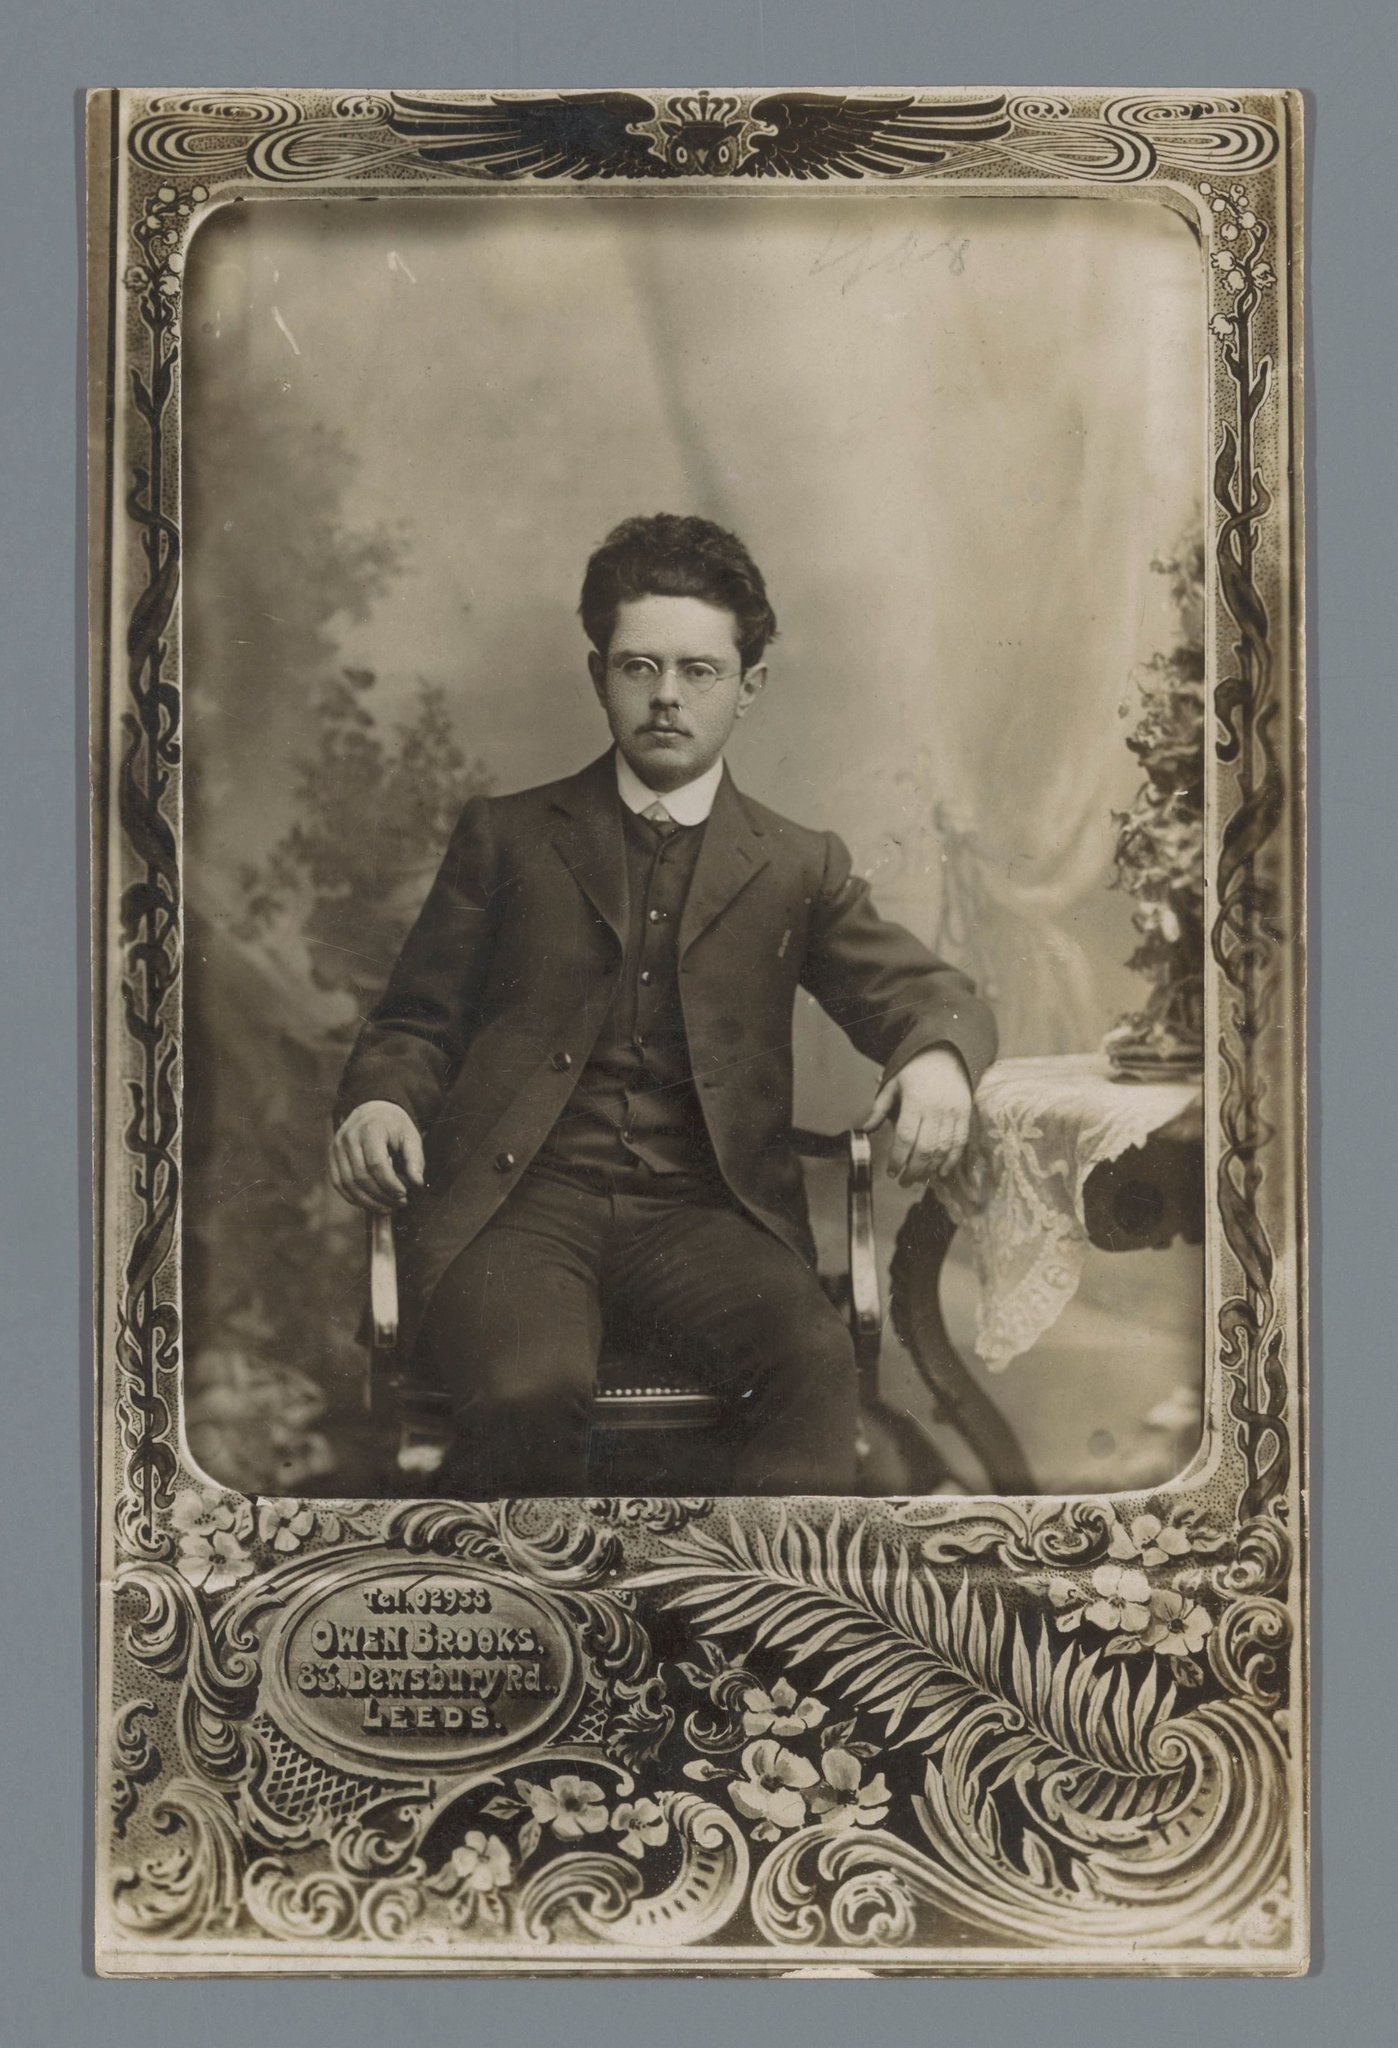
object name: photograph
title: Studioportret van een onbekende jongeman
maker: owen brooks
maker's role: fotograaf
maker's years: 1863-1947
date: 1908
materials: photographic support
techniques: gelatin silver print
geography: leeds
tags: youth, adolescent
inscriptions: inscription: ‘Leeds 15e april 1908.’, inscription: ‘Tel. 02955 Owen Brooks 83. Dewsbury Rd. Leeds.’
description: Dezelfde man is geportretteerd op RP-F-F20789 en RP-F-F20790.